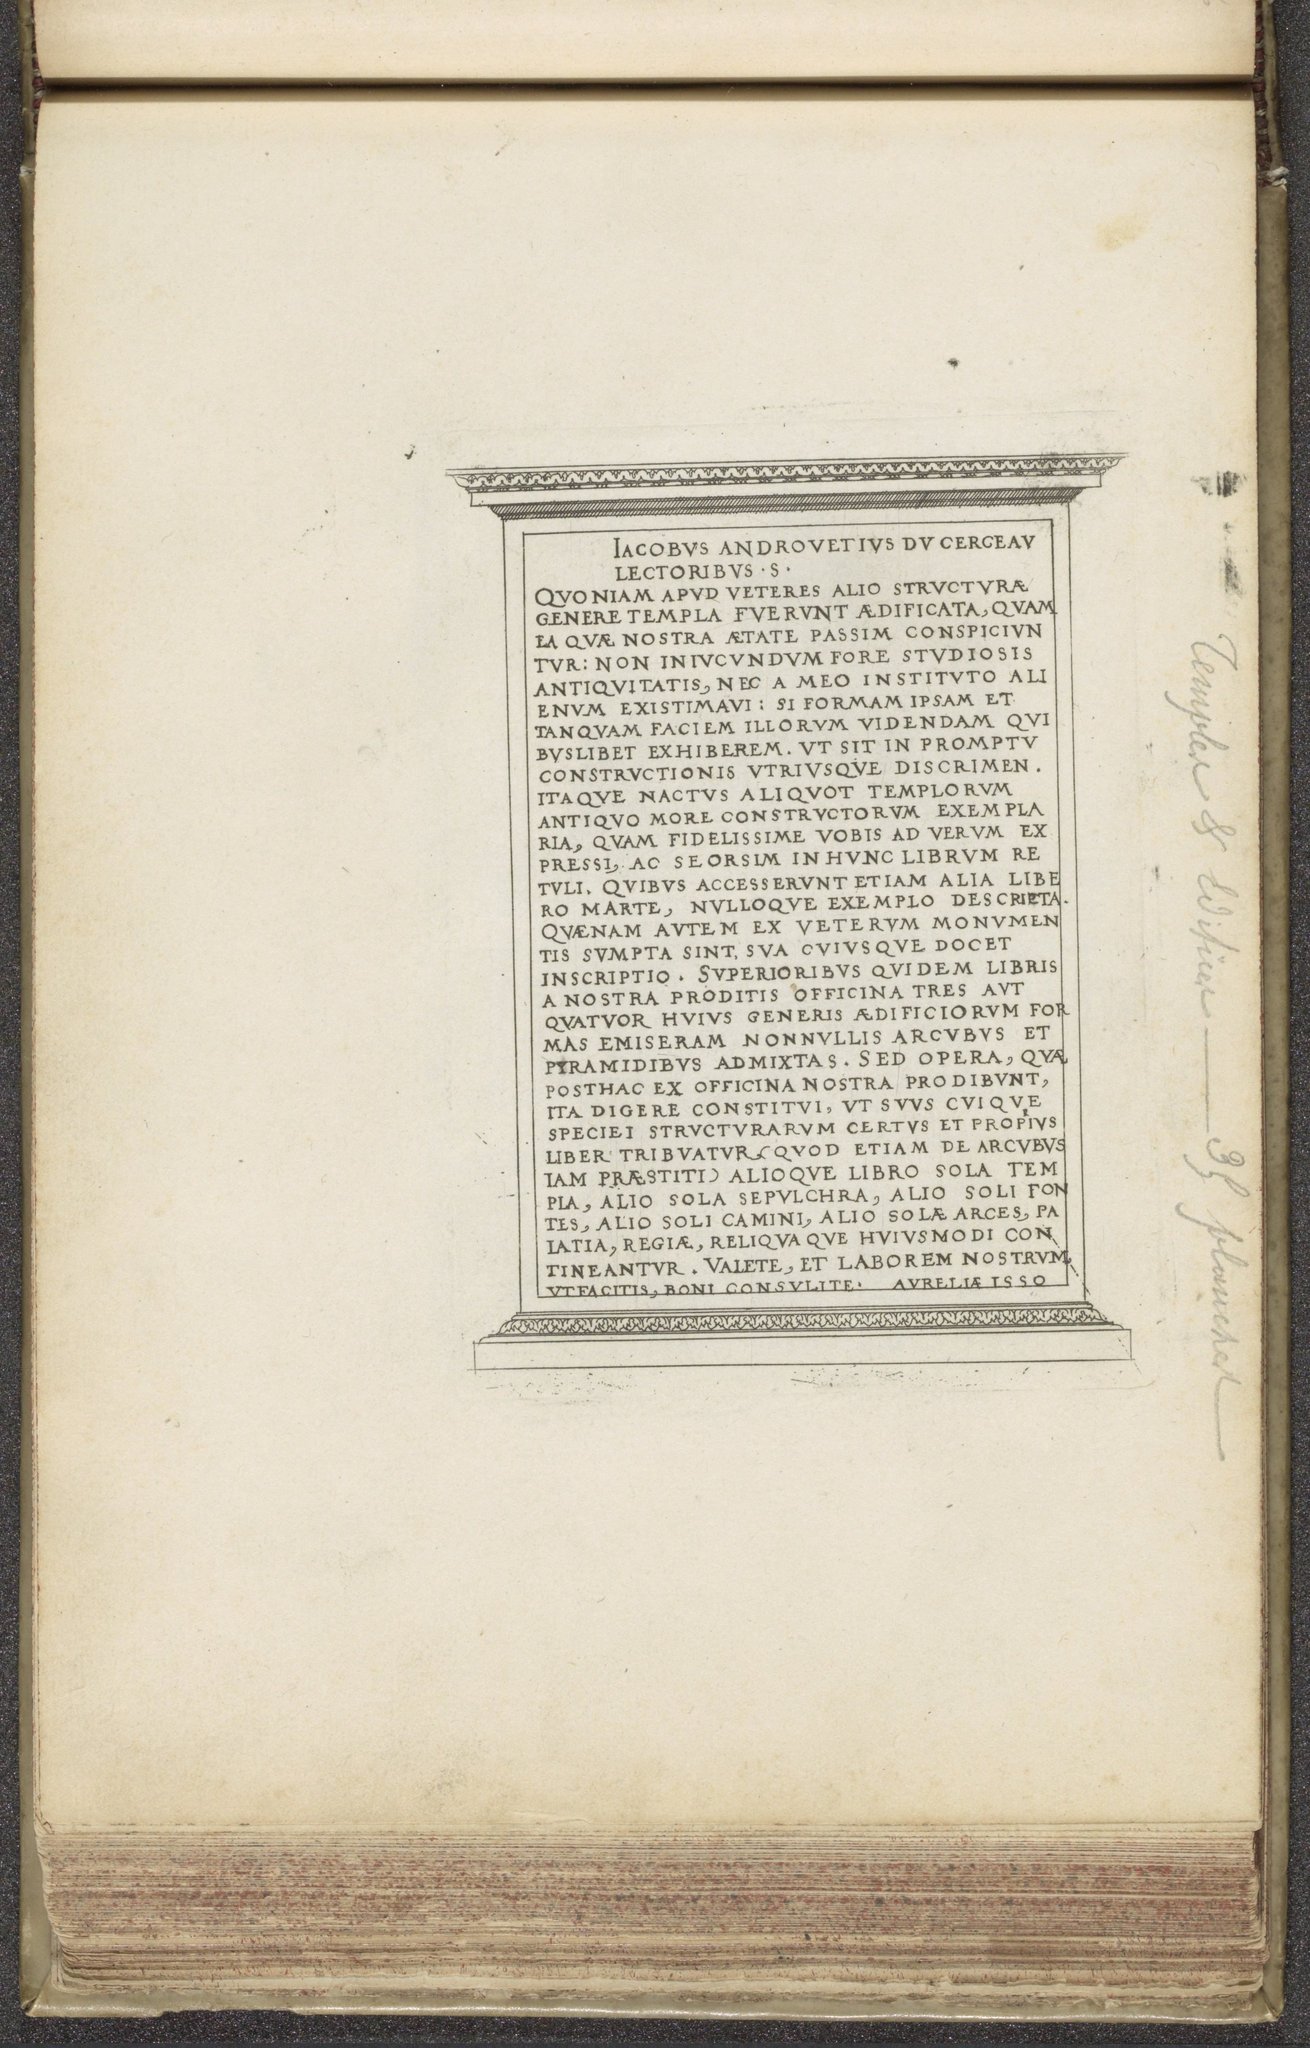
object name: print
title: Piëdestal met tekst in het Latijn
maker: jacques androuet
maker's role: draughtsman, print maker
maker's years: 1515-1584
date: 1550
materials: paper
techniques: etching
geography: orléans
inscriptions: date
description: Piëdestal met tekst in het Latijn. Titelprent voor een serie van tempels en kerken. Deze prent maakt deel uit van een album.